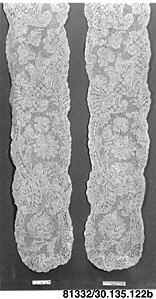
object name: lappet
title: Lappets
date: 1701-1800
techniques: lace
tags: flowers